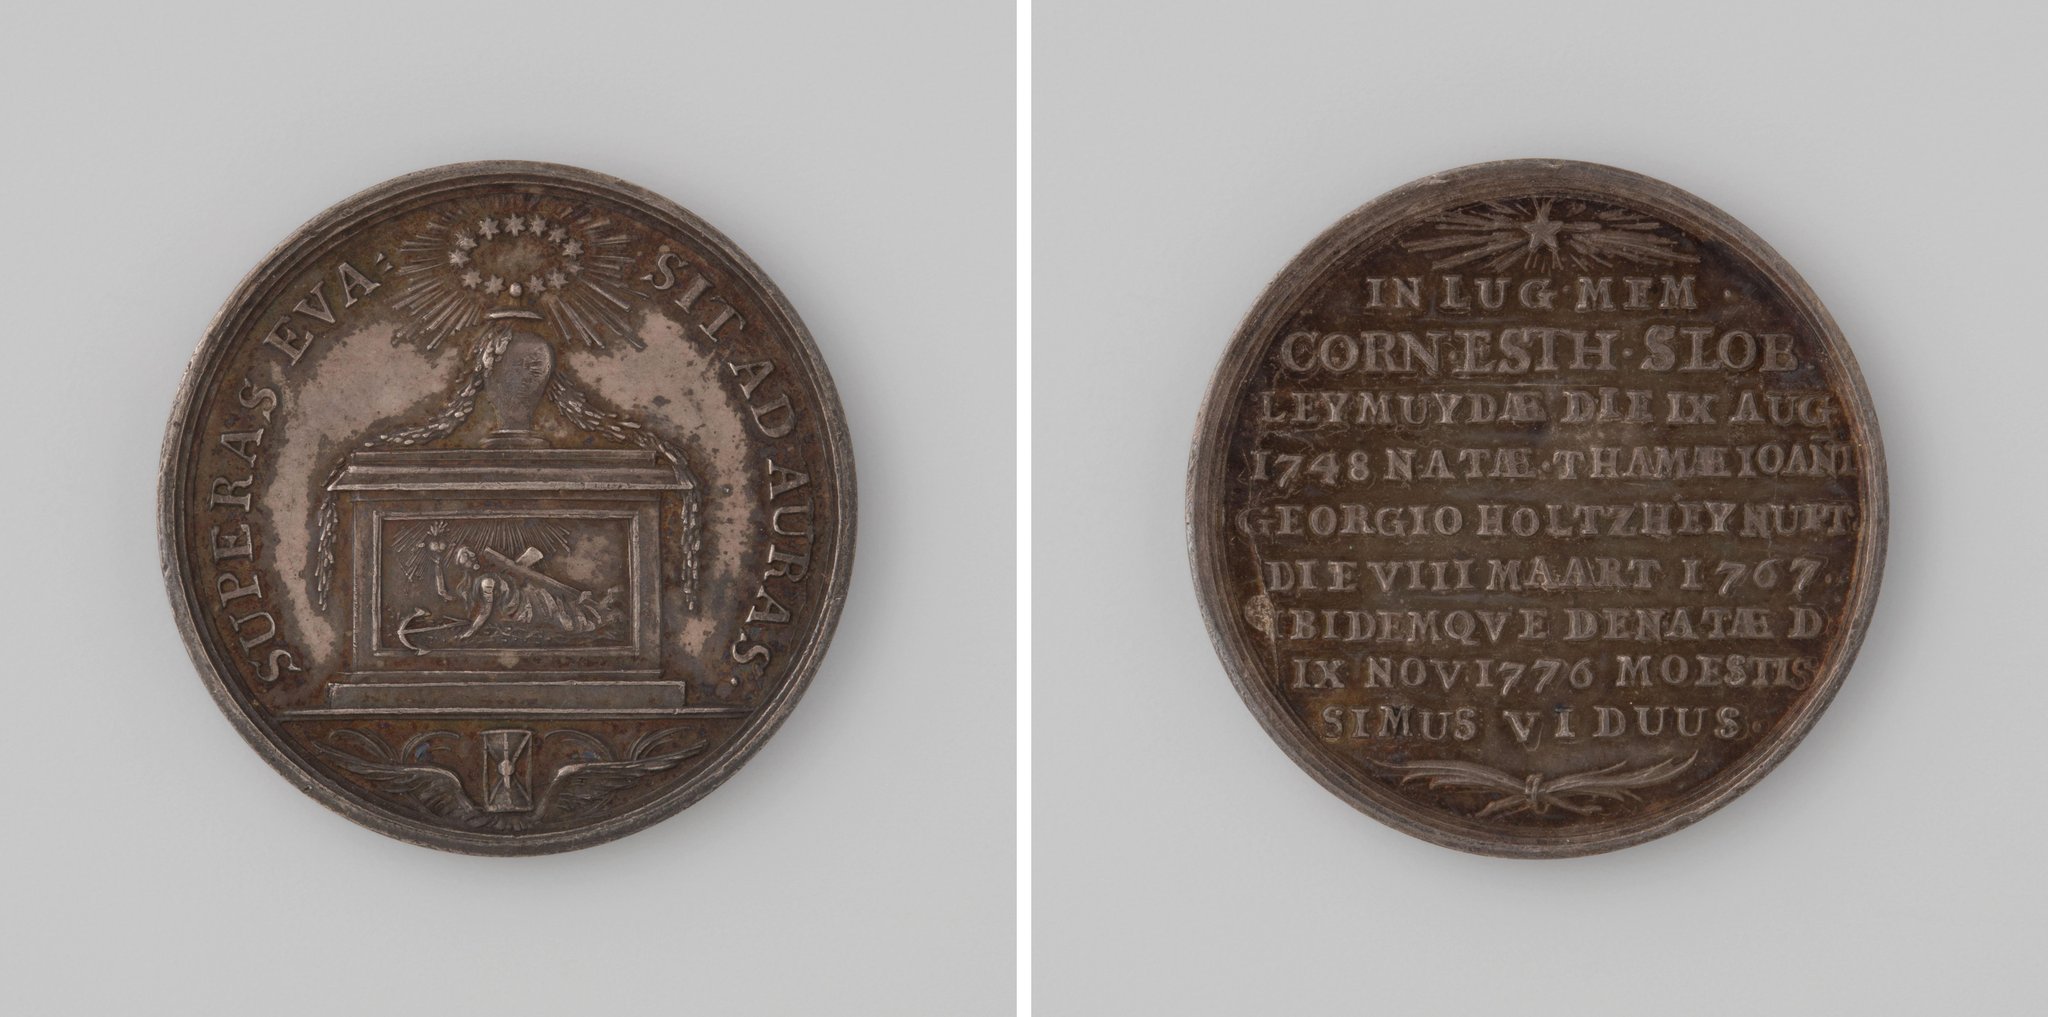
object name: family medal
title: Overlijden van Cornelia Esther Slob, echtgenote van de medailleur Johan George Holtzhey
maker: johan george holtzhey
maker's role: mintmaster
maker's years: 1726-1808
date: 1776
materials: silver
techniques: striking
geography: amsterdam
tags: amsterdam, mintmaster, johan george holtzhey